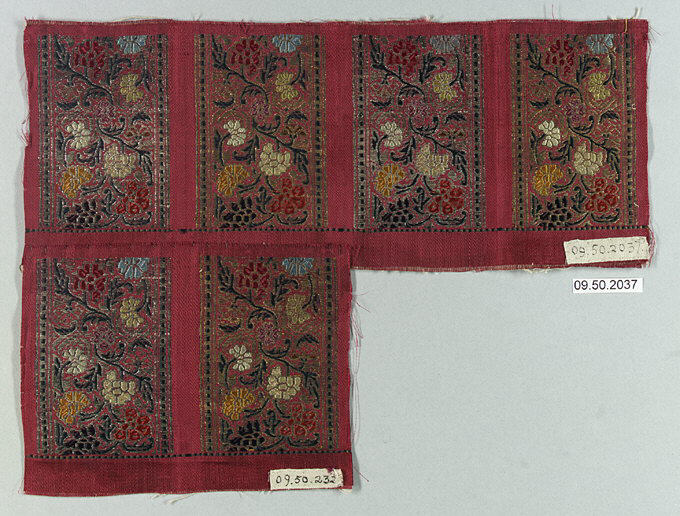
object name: textile fragment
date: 1801-1900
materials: metal thread, silk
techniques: brocade, satin weave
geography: india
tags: flowers